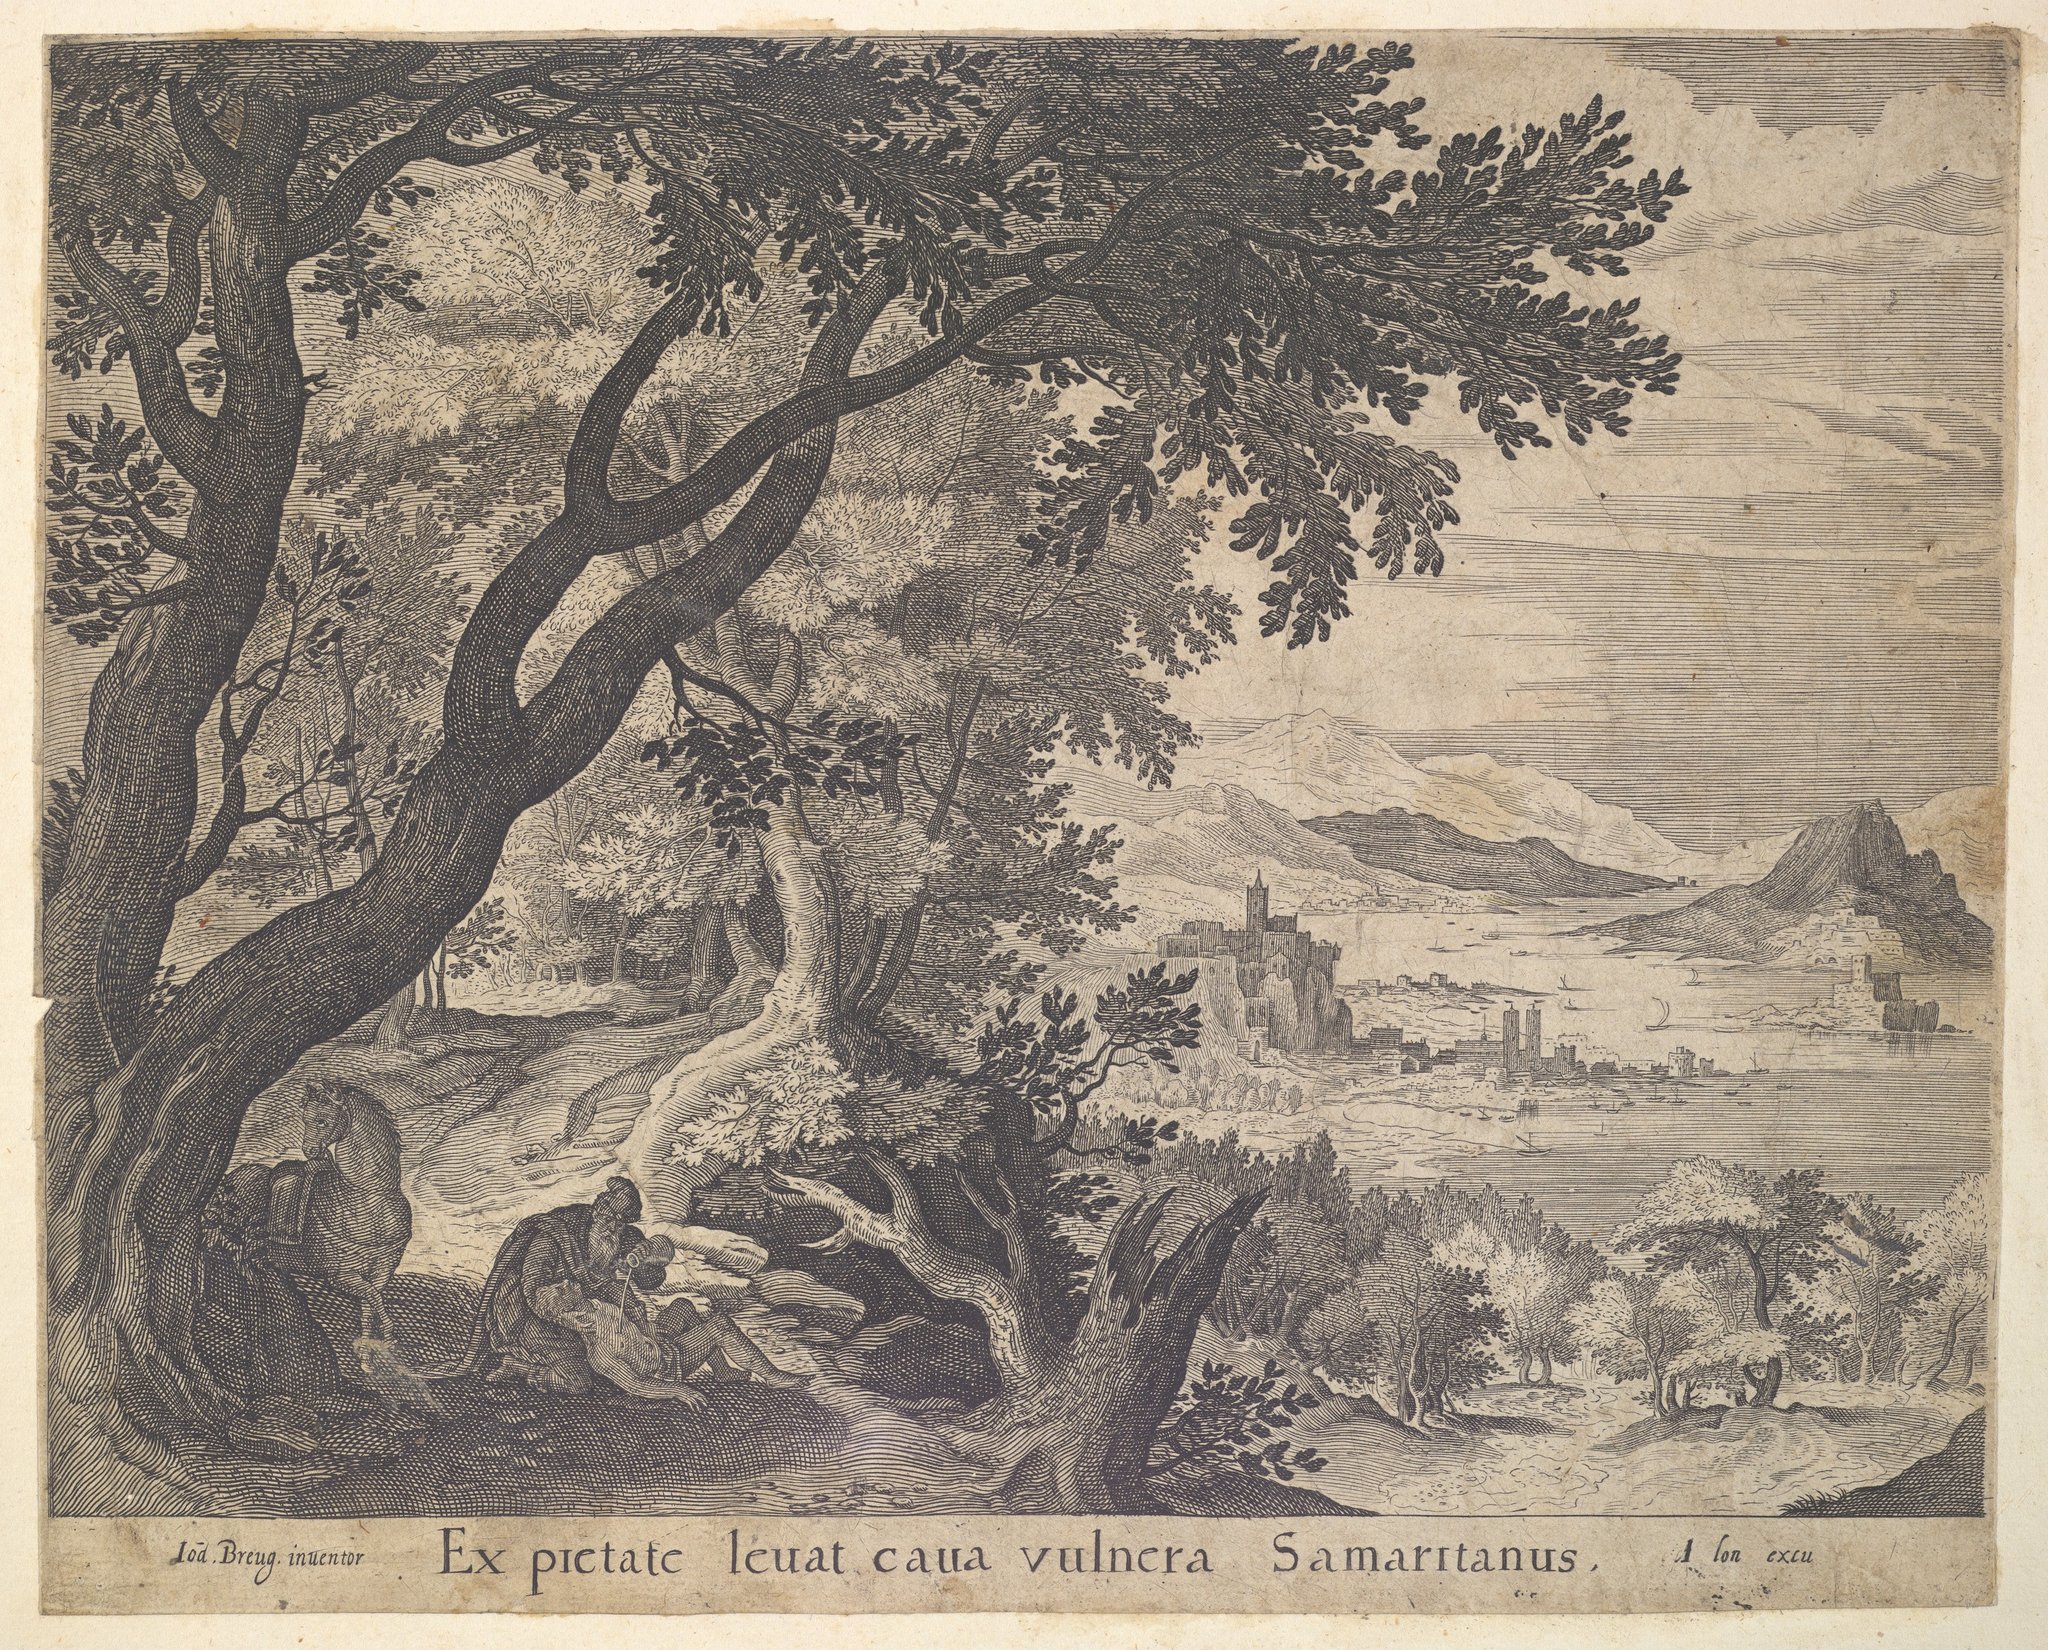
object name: print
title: The Good Samaritan Finds the Man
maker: jan brueghel the elder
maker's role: artist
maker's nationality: netherlandish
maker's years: 1568-1625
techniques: engraving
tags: men,horses,landscapes